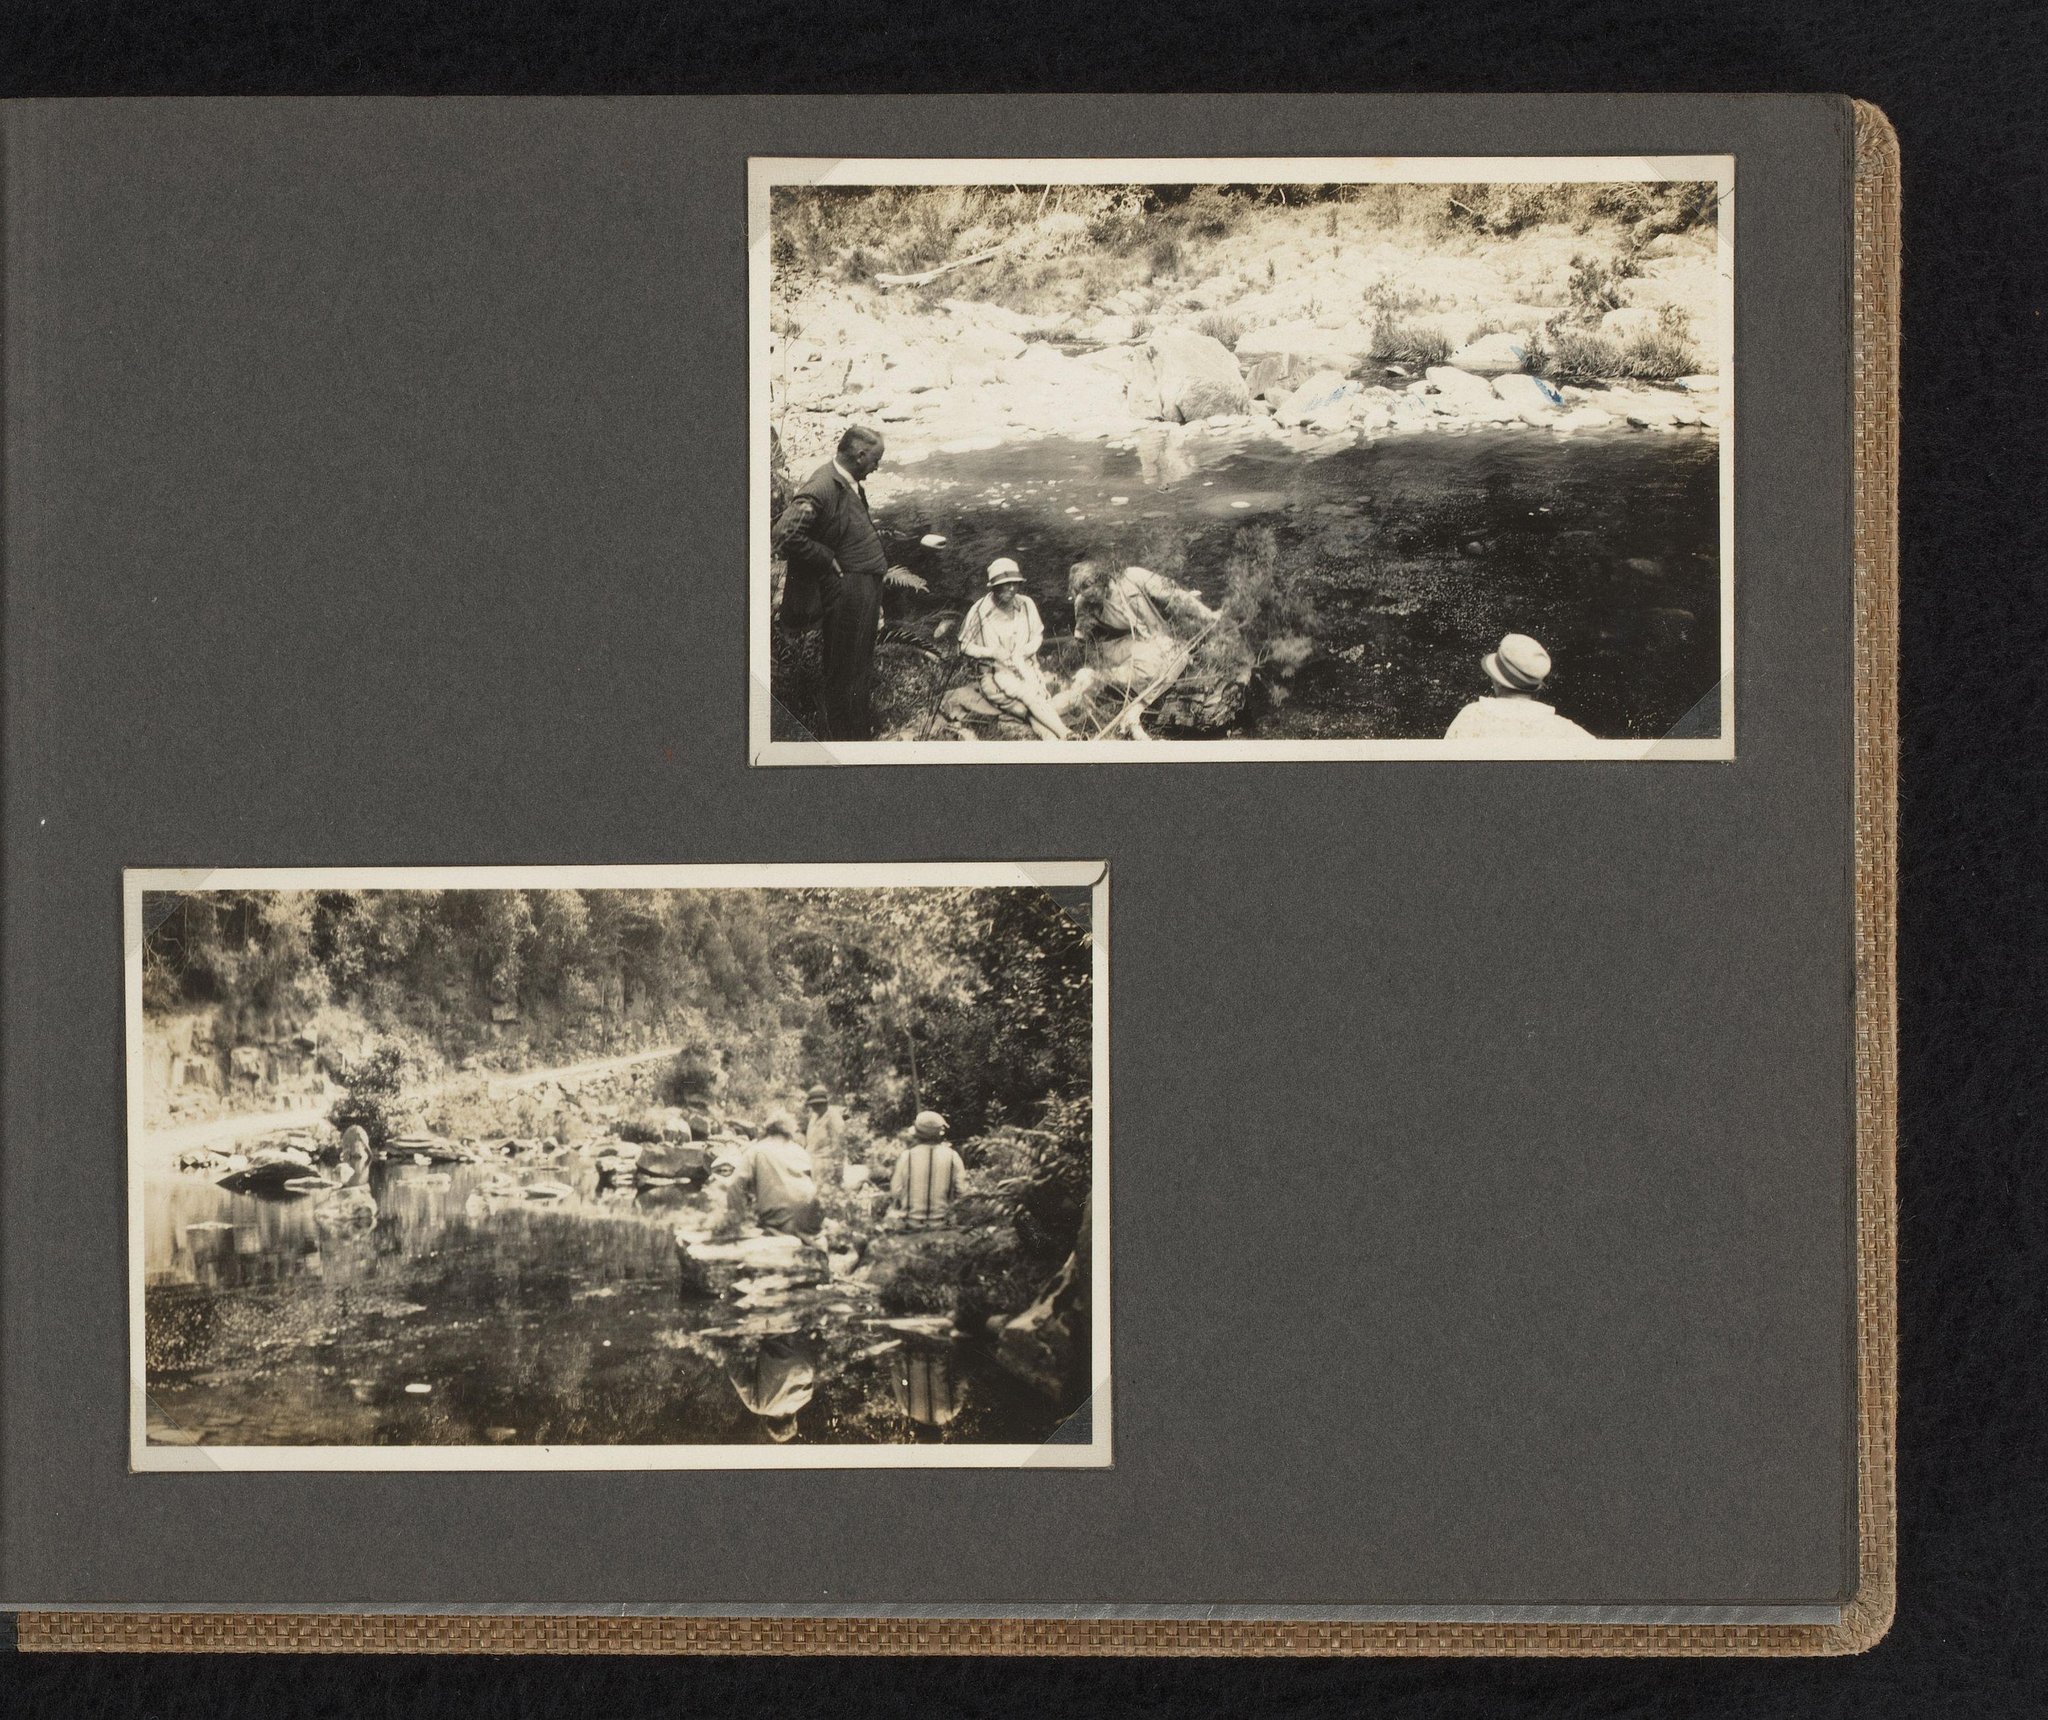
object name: photograph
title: Gezelschap bij een beek, vermoedelijk in Zuid-Afrika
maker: karel frederik van den berg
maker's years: 1873-1948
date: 1925-1930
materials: paper, cardboard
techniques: gelatin silver print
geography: south africa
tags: brook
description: Deze foto's zijn onderdeel van een album.